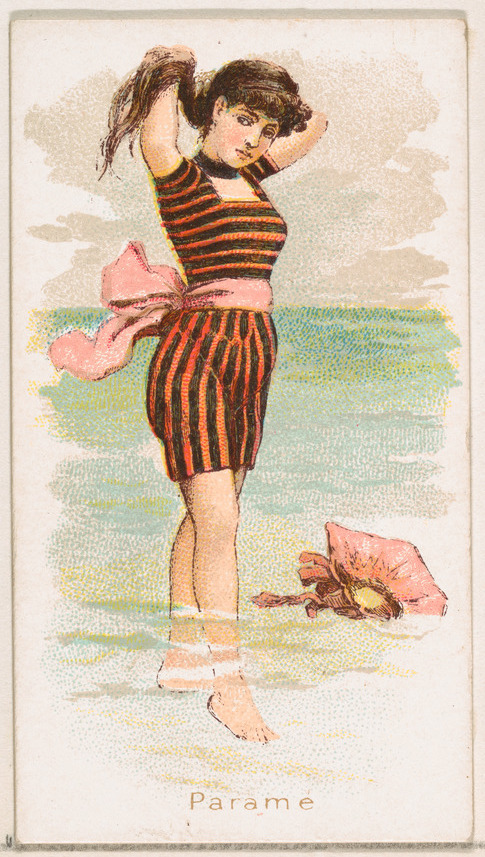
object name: print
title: Parame, from the Fancy Bathers series (N187) issued by Wm. S. Kimball & Co.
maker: william s. kimball & company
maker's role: publisher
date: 1889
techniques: color lithograph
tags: women